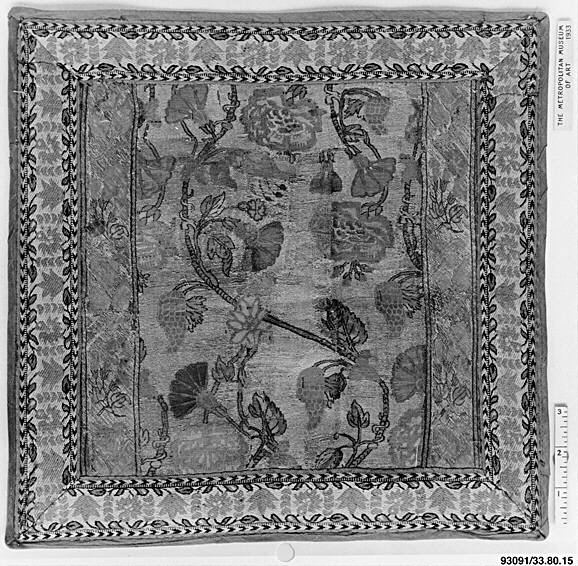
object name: joined fragment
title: Joined Fragments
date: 1601-1650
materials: metal thread, silk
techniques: brocade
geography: iran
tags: flowers,leaves